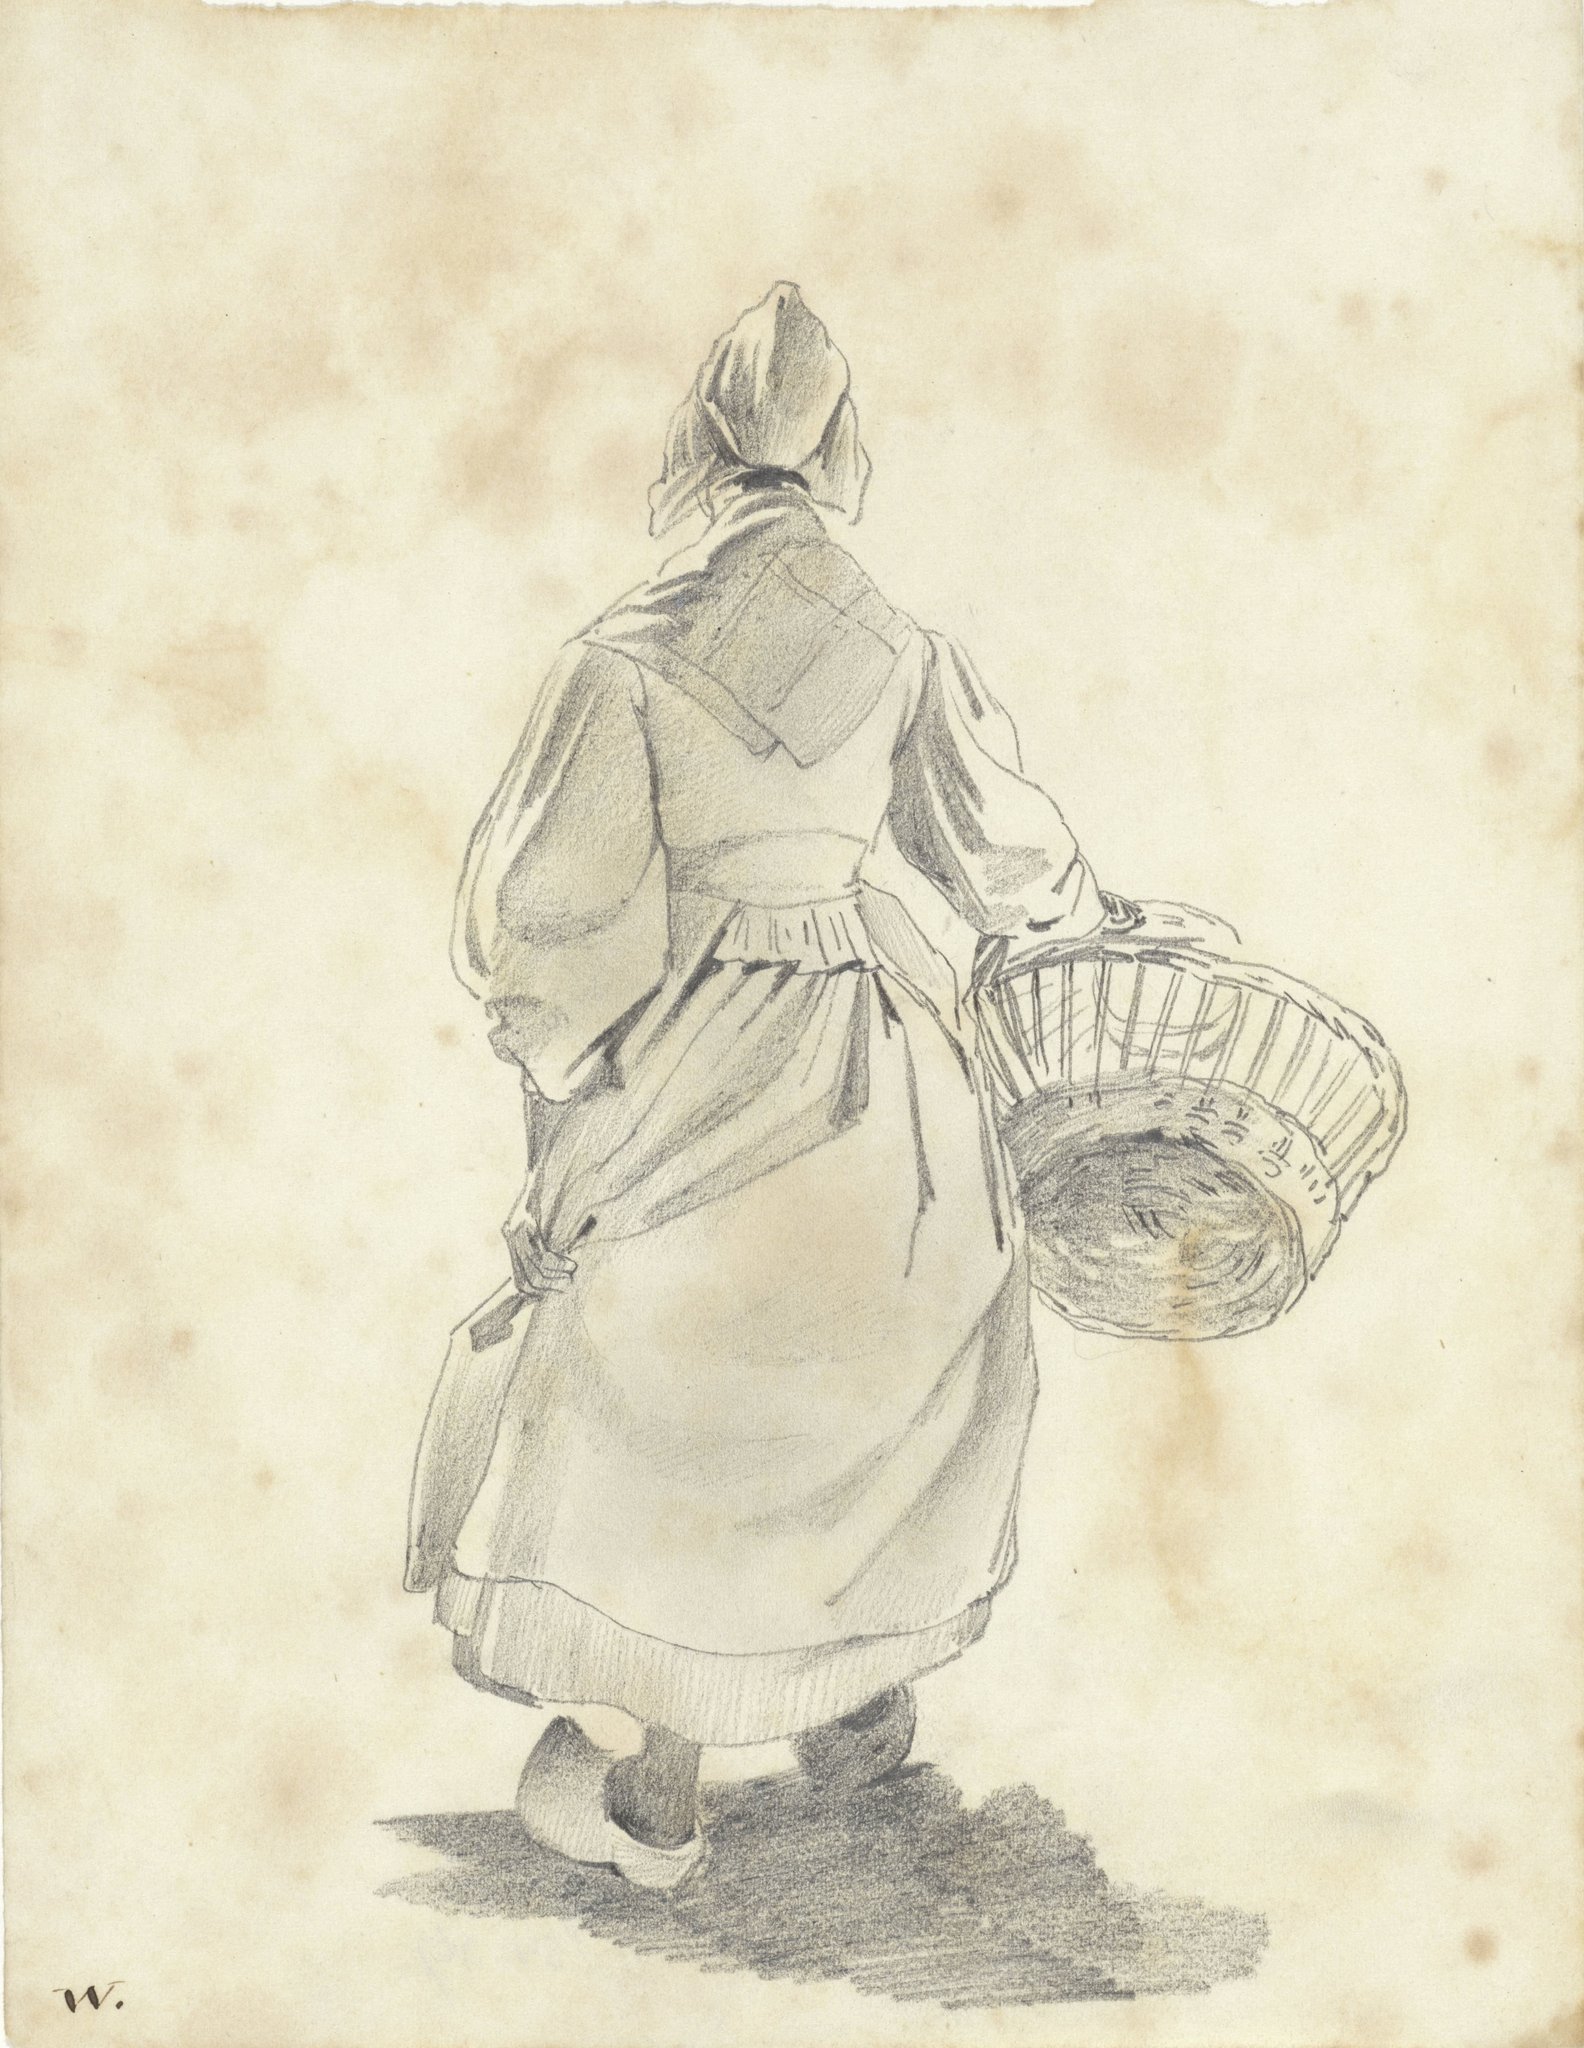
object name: drawing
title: Staande vrouw met mand, op de rug gezien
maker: pieter van loon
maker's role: draughtsman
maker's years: 1801-1873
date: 1811-1873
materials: paper, pencil